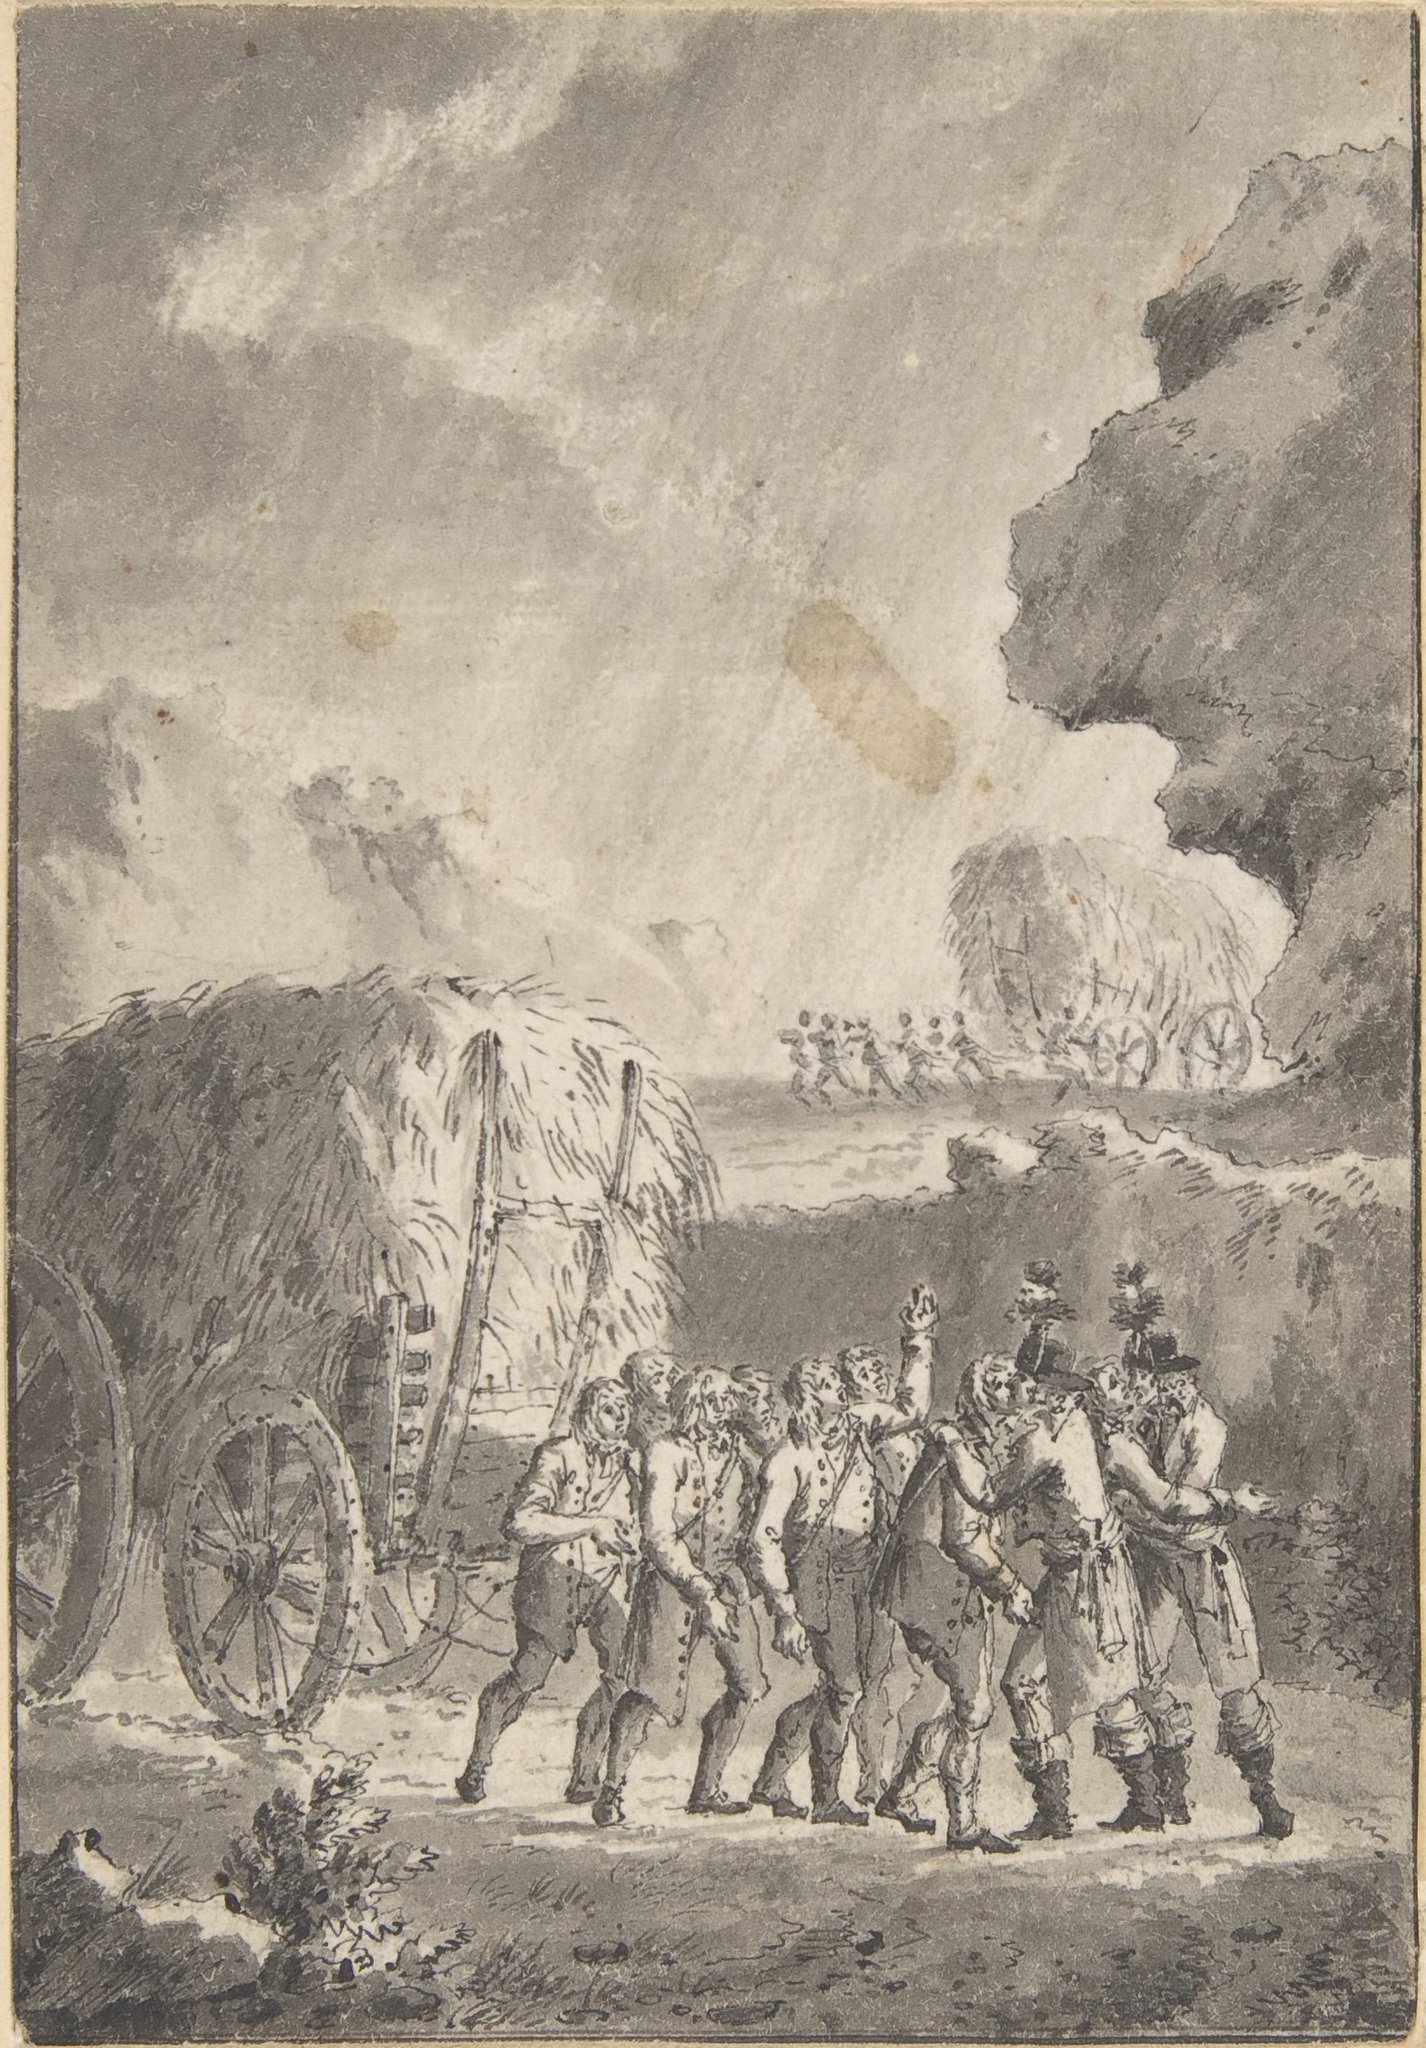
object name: drawing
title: Drawing for a plate from "Gravures historiques des principaux événements Depuis l'Ouverture des Etats Generaux..."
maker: jean françois janinet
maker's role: artist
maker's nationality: french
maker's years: 1752-1814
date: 1789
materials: ink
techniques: brush, pen, wash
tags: men,trees,carriages